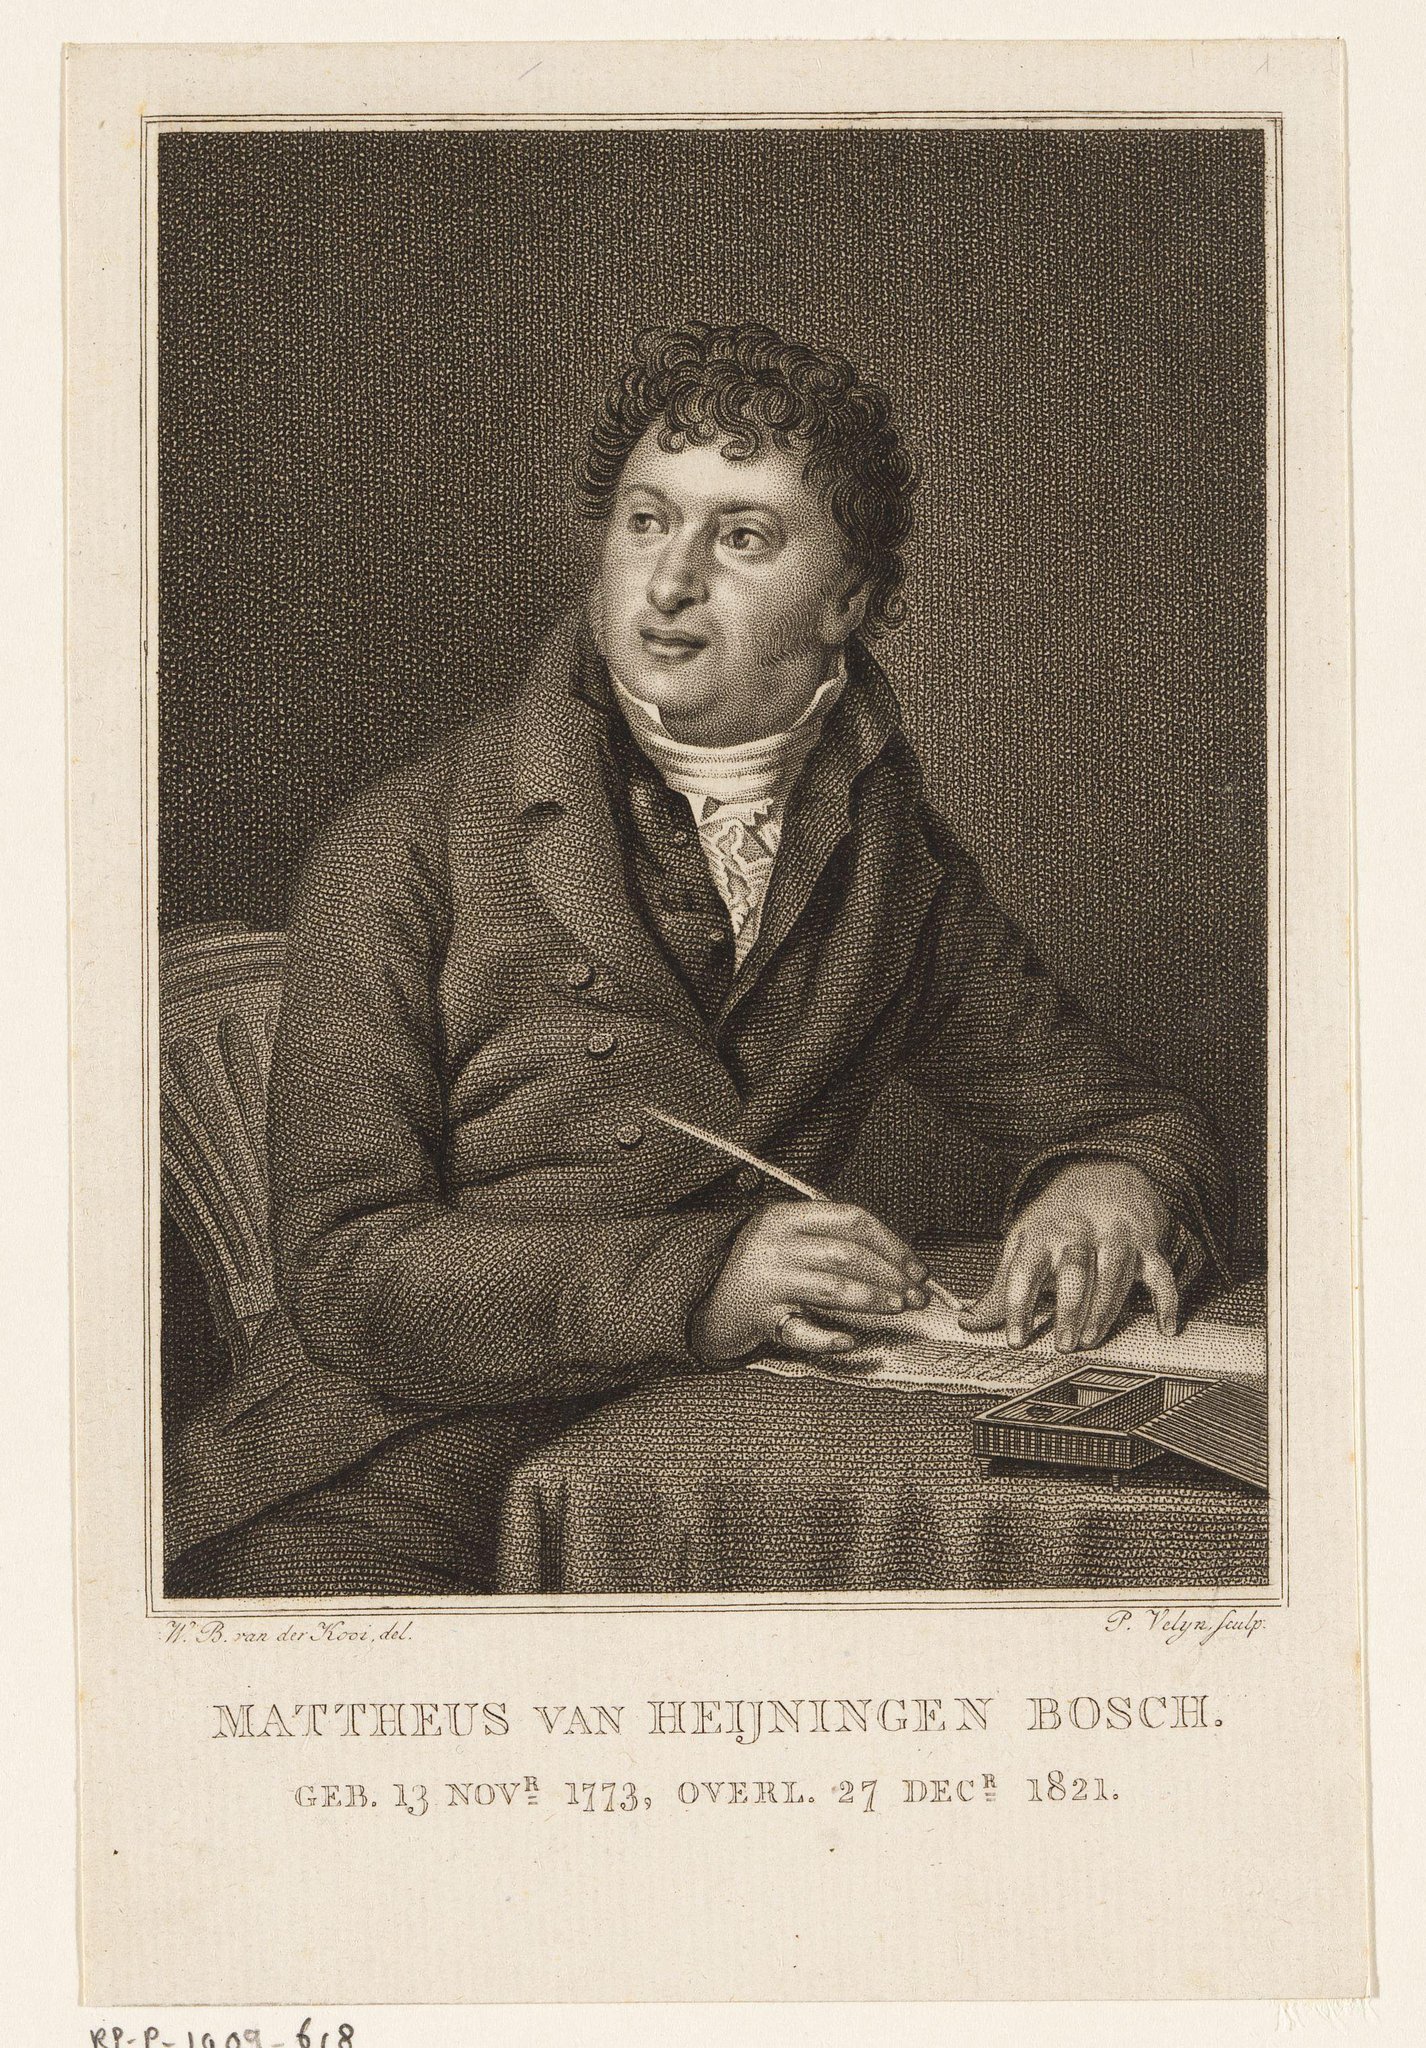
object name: print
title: Portret van Matheus van Heyningen Bosch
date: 1821-1836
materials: paper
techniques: engraving, etching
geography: netherlands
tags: matheus van heyningen bosch, writing accessories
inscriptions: collector's mark: Lugt 2228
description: Portret van de Nederlandse schrijver Matheus van Heyningen Bosch.